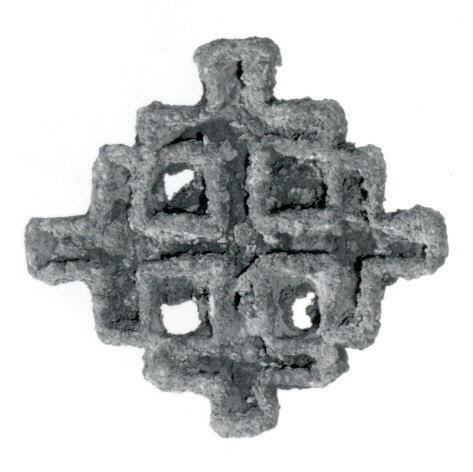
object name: stamp seal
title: Compartmented stamp seal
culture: bactria-margiana archaeological complex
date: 2333-1668 BCE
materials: copper alloy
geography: bactria-margiana